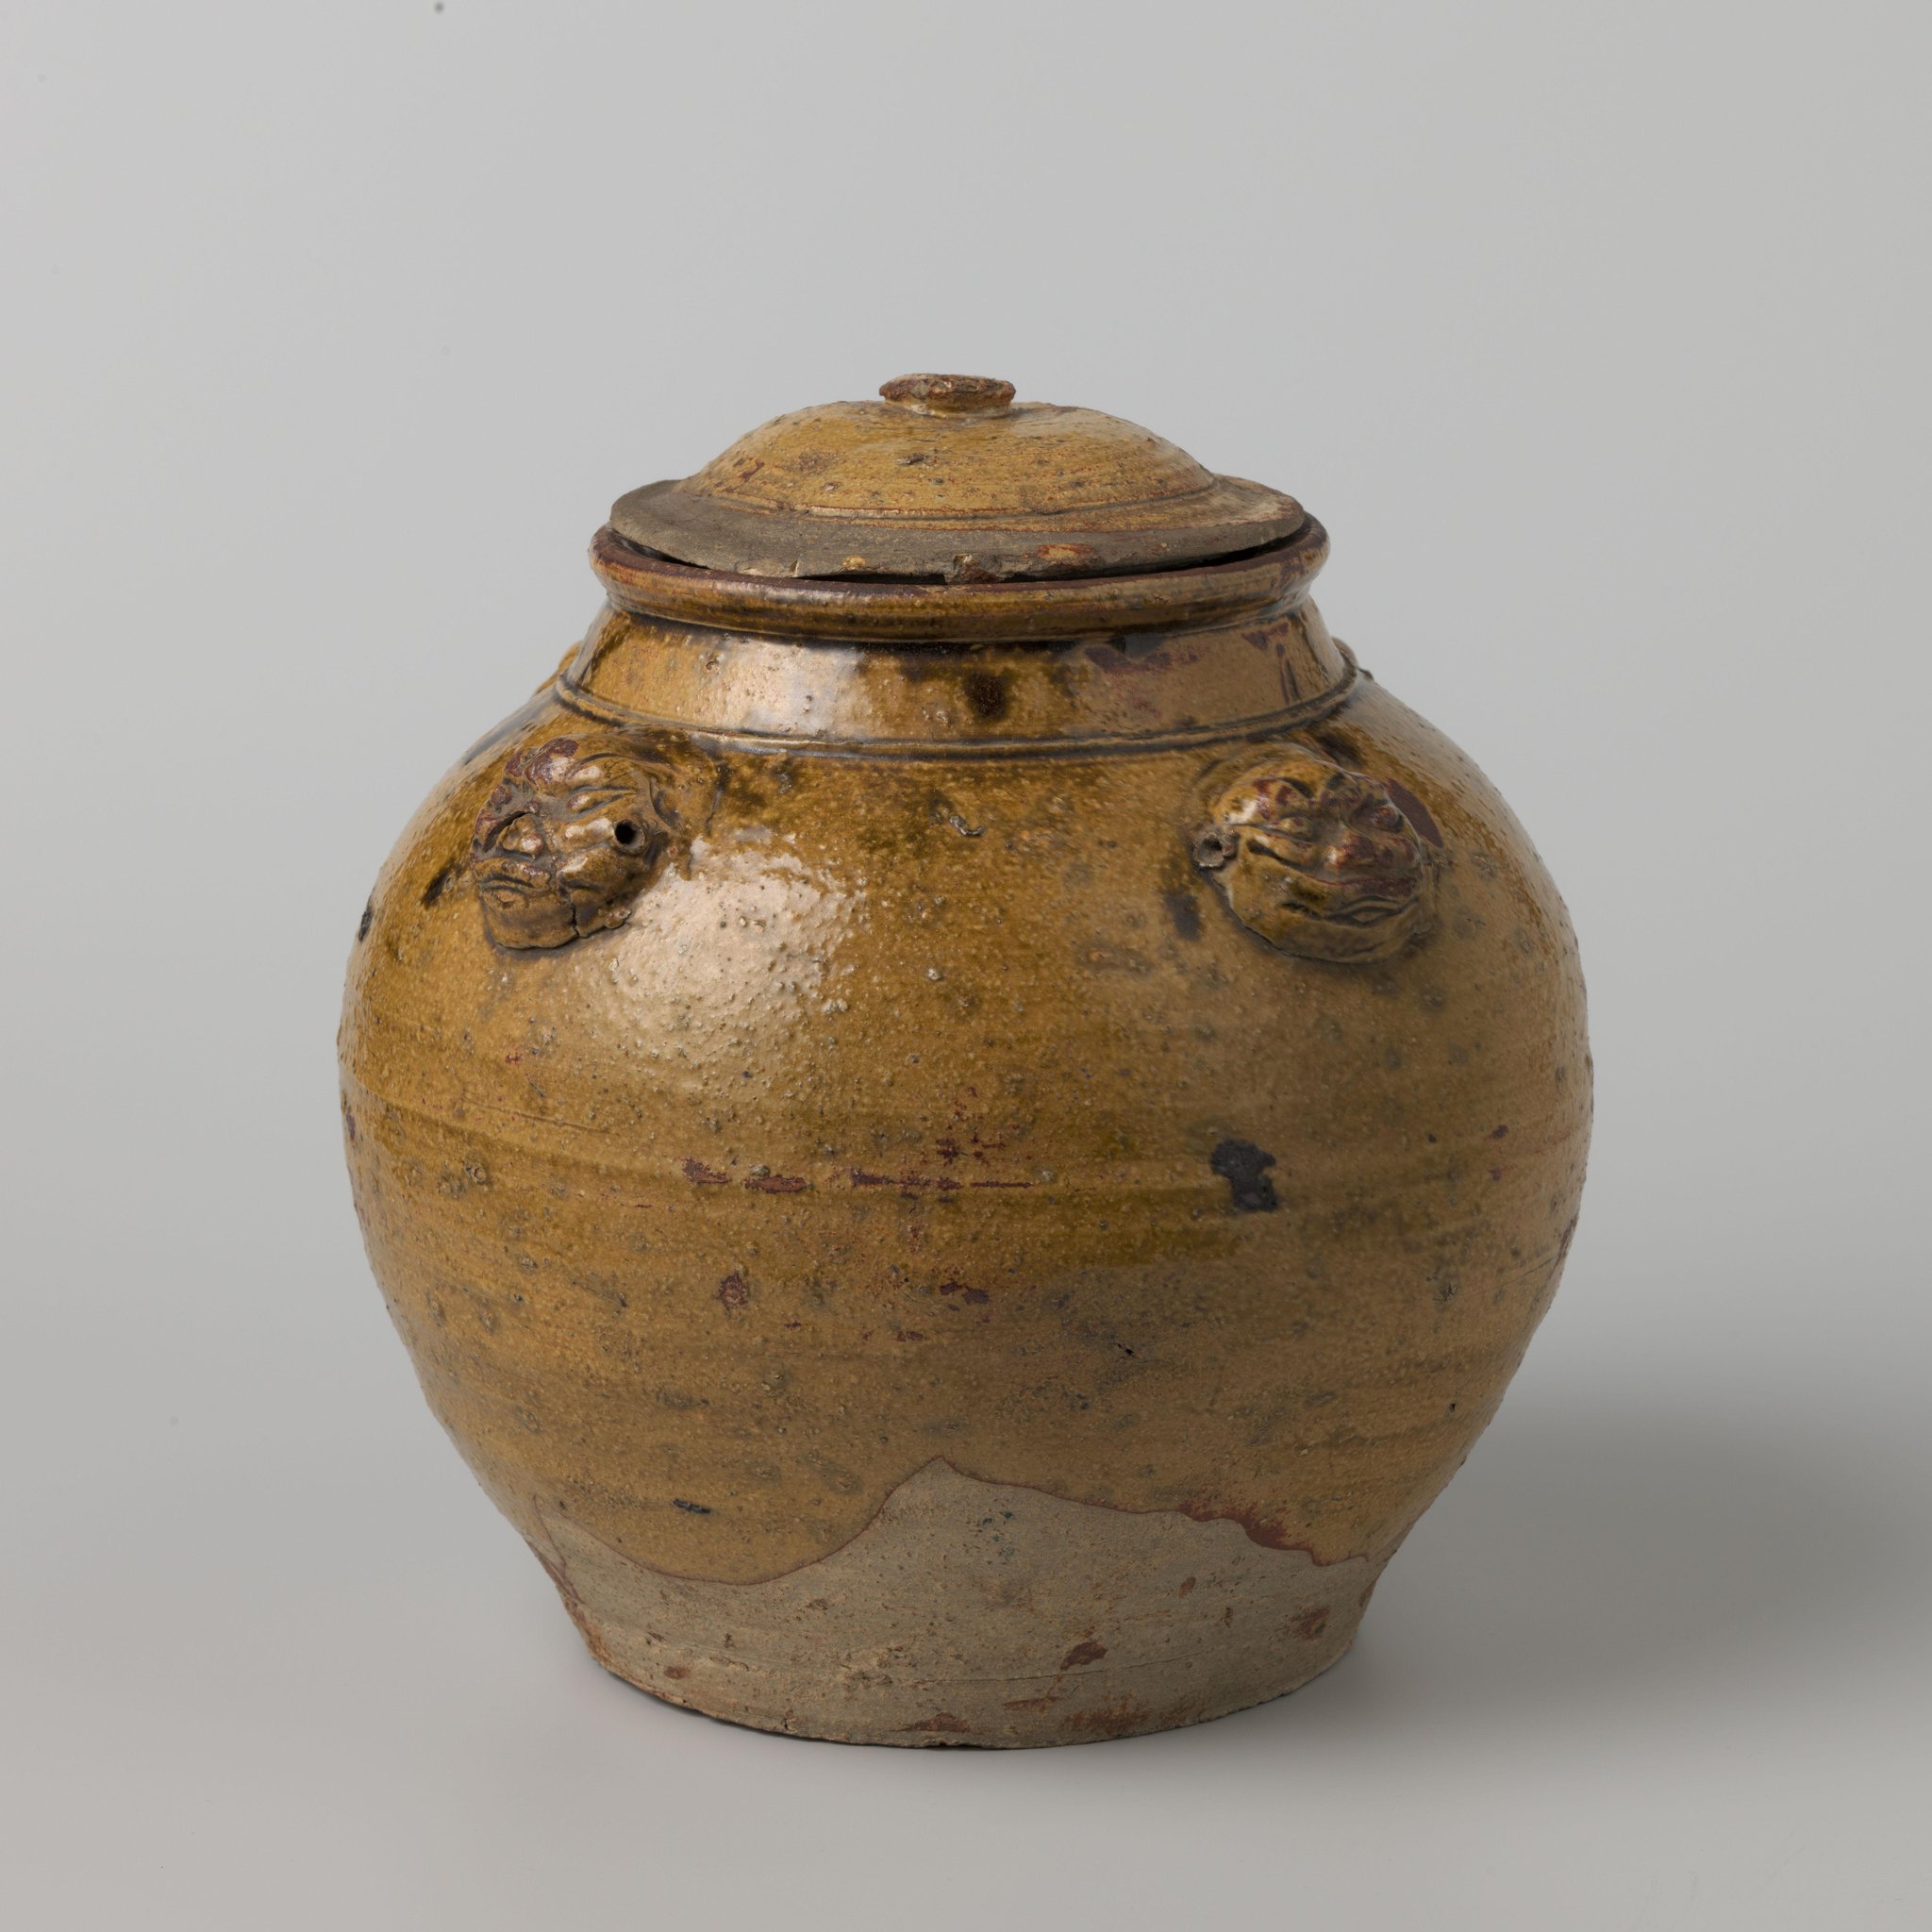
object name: covered jar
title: Ovoid covered jar with four moulded monster heads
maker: Anonymous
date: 1800-1899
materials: earthenware, glaze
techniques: firing, forming, turning, vitrification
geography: china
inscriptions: label: ‘Br. Jeltes no. 22’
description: Eivormige dekselpot van aardewerk met een korte hals en platte rand, gedeeltelijk bedekt met een geel glazuur. Op de schouder viermaal een gemodelleerde monsterkop. Het onderste deel van de buik en de onderzijde zijn ongeglazuurd. De deksel heeft een platte knop. Deksel is gebroken geweest. Oud label op de wand met 'Br. Jeltes no. 22'.